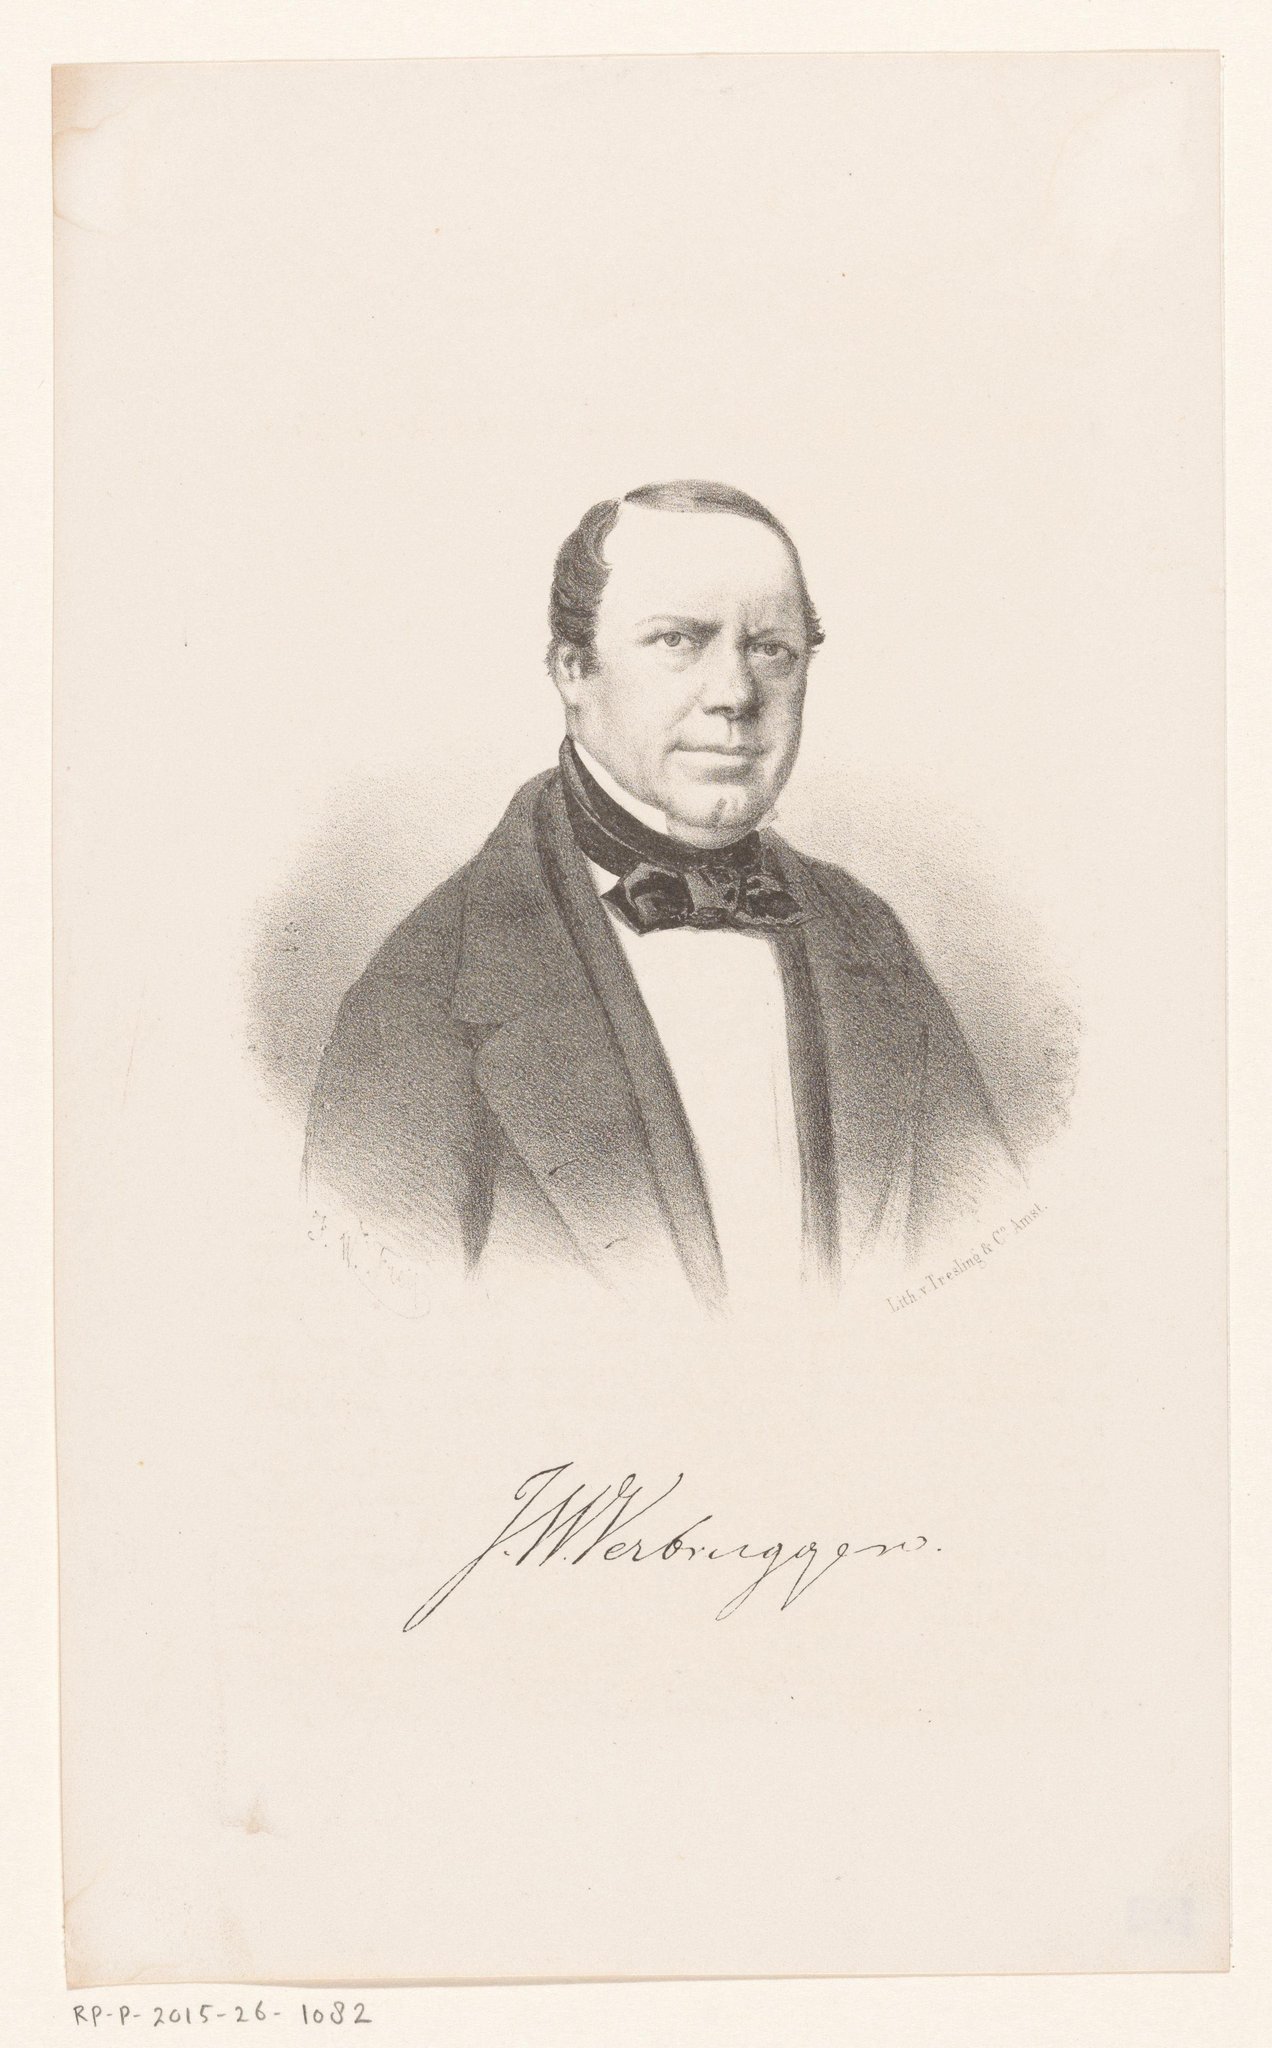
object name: print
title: Portret van Johannes Wilhelmus Verbruggen, boekhandelaar te Rotterdam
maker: johann wilhelm frey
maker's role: print maker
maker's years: 1830-1890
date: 1865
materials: paper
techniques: lithograph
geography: amsterdam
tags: rotterdam, publisher, book-shop, bookseller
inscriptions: collector's mark: Lugt 4780, collector's mark: Lugt 2228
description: Volgens Van Someren is de prent ook gebruikt in: Adresboek voor den Nederlandschen boekhandel, 1865.